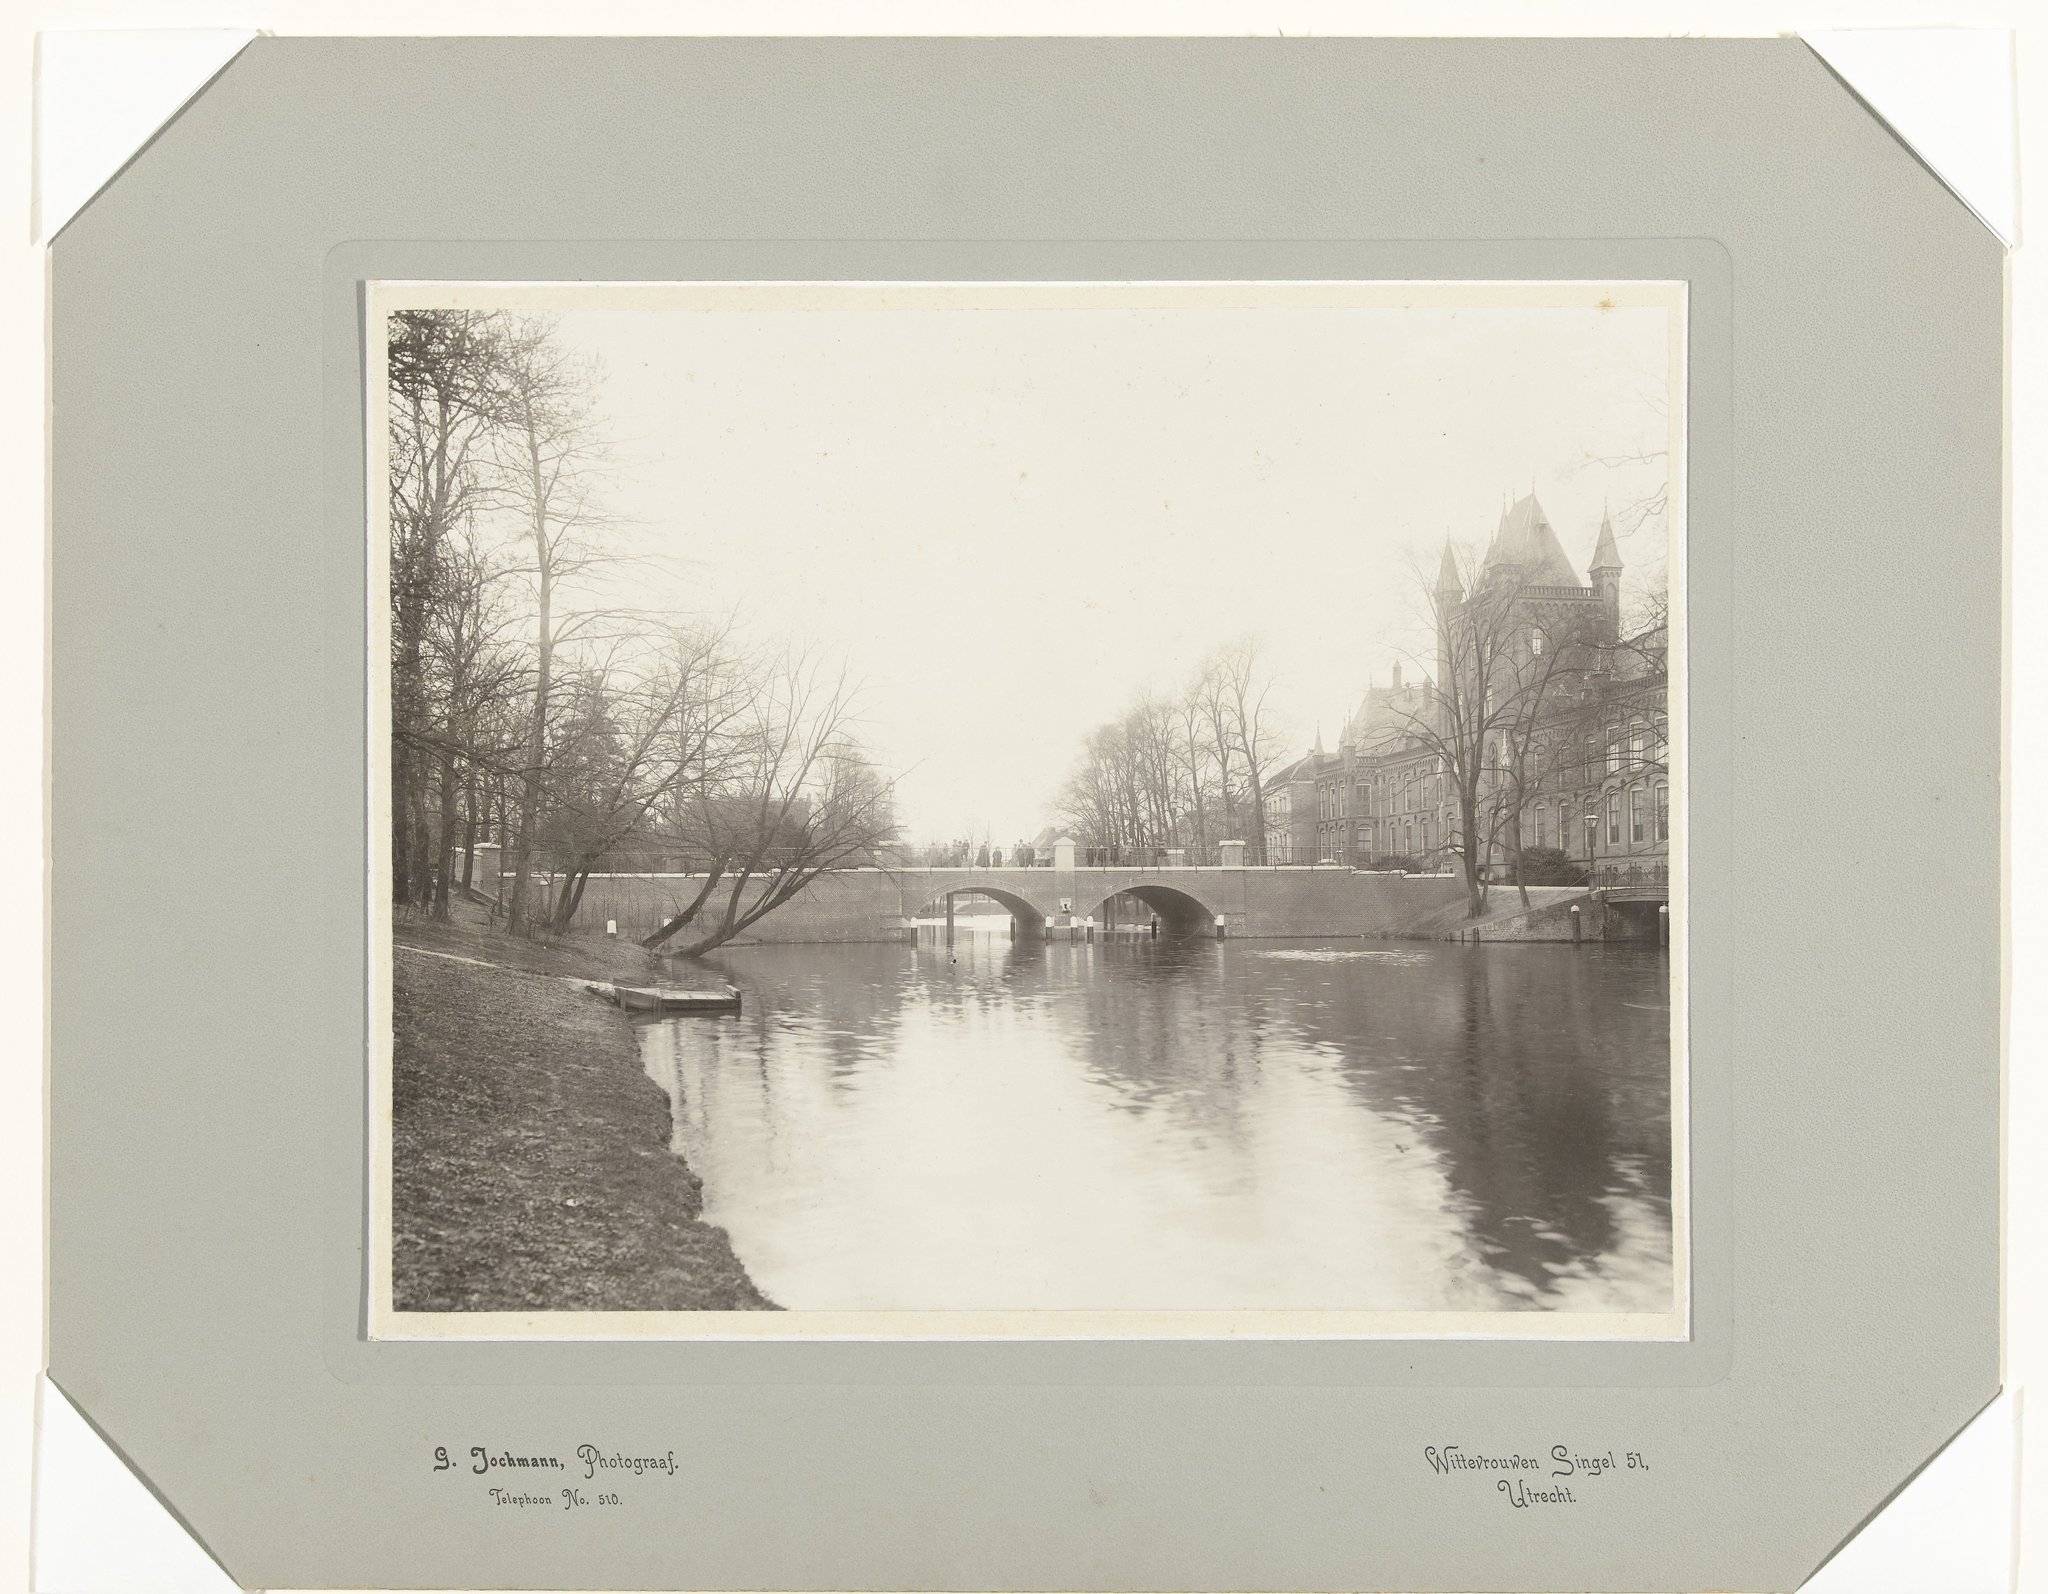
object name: photograph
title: Zicht op de Wittevrouwensingel te Utrecht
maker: gustav johan erik jochmann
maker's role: fotograaf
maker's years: 1865-1941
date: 1900-1940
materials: cardboard, paper, photographic support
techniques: gelatin silver print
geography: utrecht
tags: landscape with bridge, viaduct or aqueduct, canal, utrecht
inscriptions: inscription: ‘Wittevrouwen Singel 51, Utrecht’